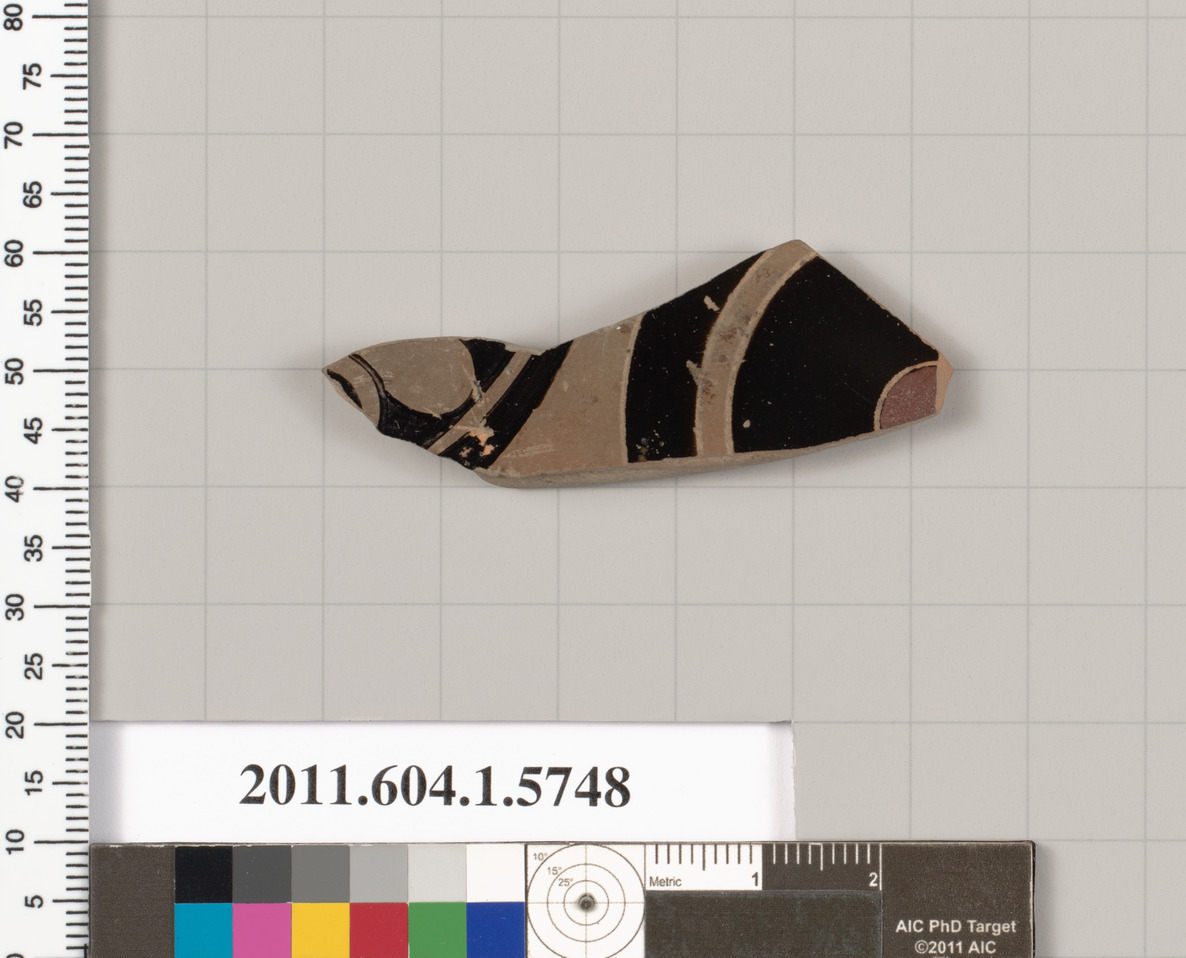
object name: kylix fragment, eye cup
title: Terracotta fragment of a kylix: eye-cup (drinking cup)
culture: greek, attic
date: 525-510 BCE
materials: terracotta